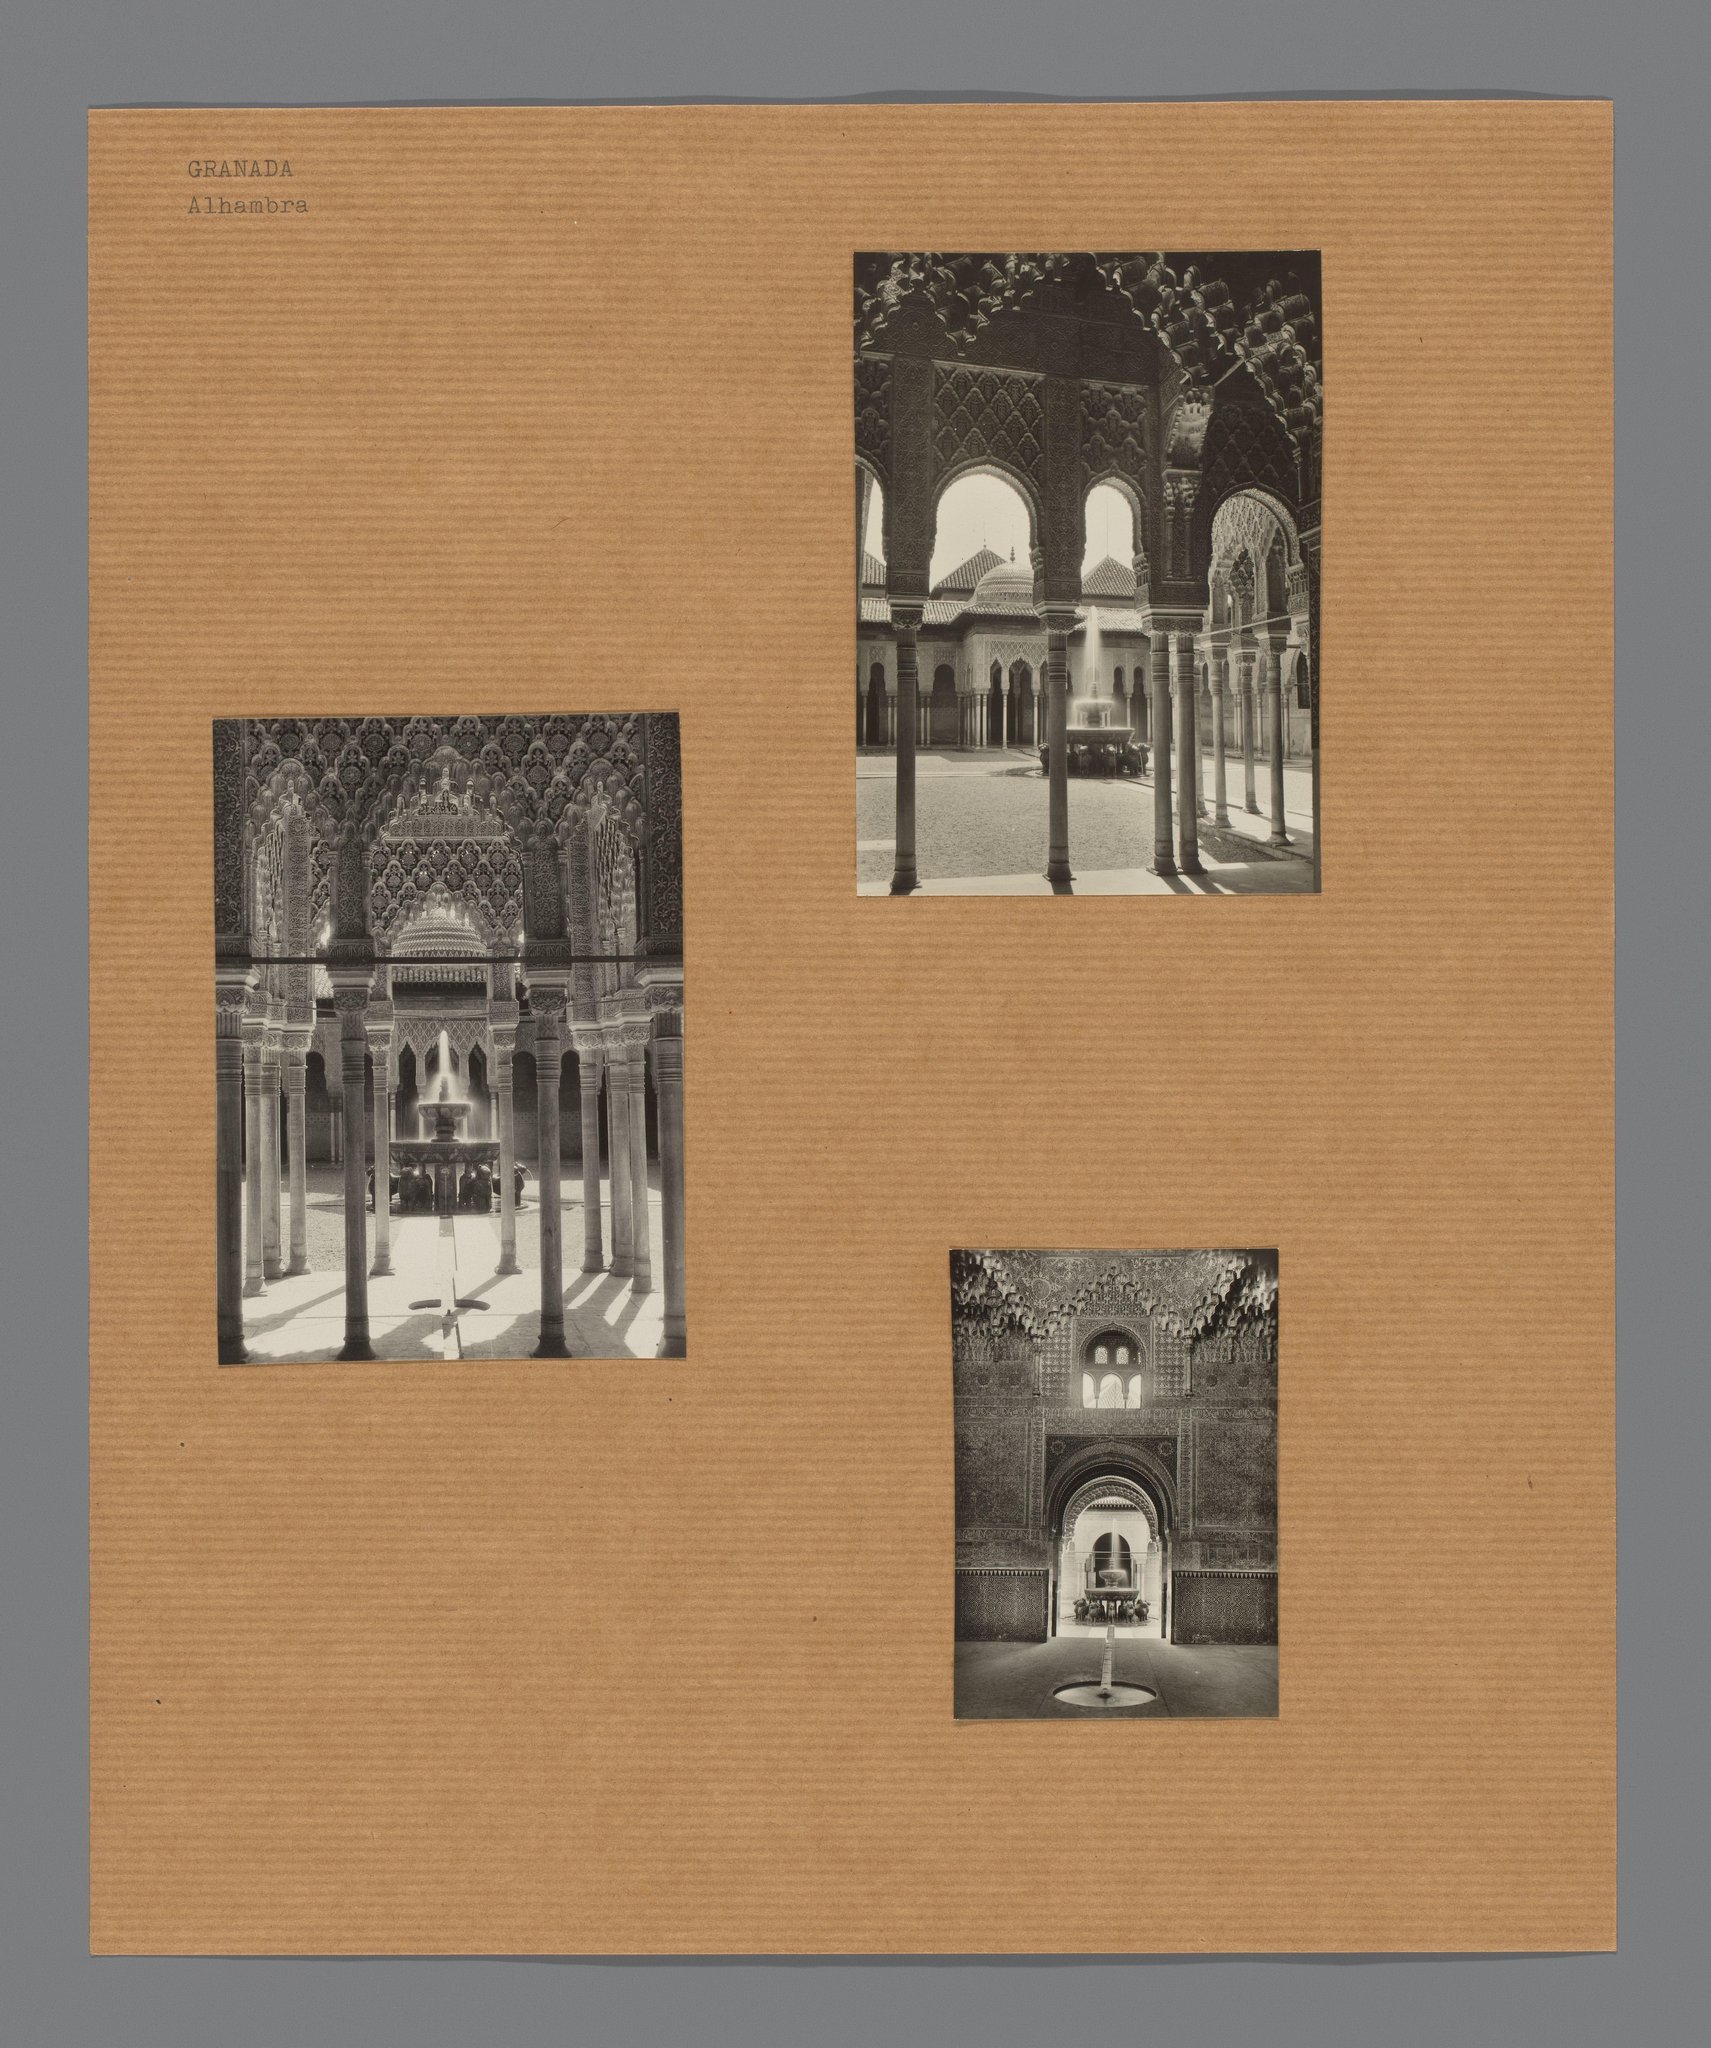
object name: photograph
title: Alhambra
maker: Anonymous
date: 1885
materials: paper, photographic support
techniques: gelatin silver print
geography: spain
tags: alhambra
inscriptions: inscription, stamp: ‘UNIVERSITEIT VAN AMSTERDAM / KUNST / HISTORISCH / INSTITUUT’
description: Vel met drie foto's uit de studiecollectie van het Kunsthistorisch Instituut van de Universiteit van Amsterdam.